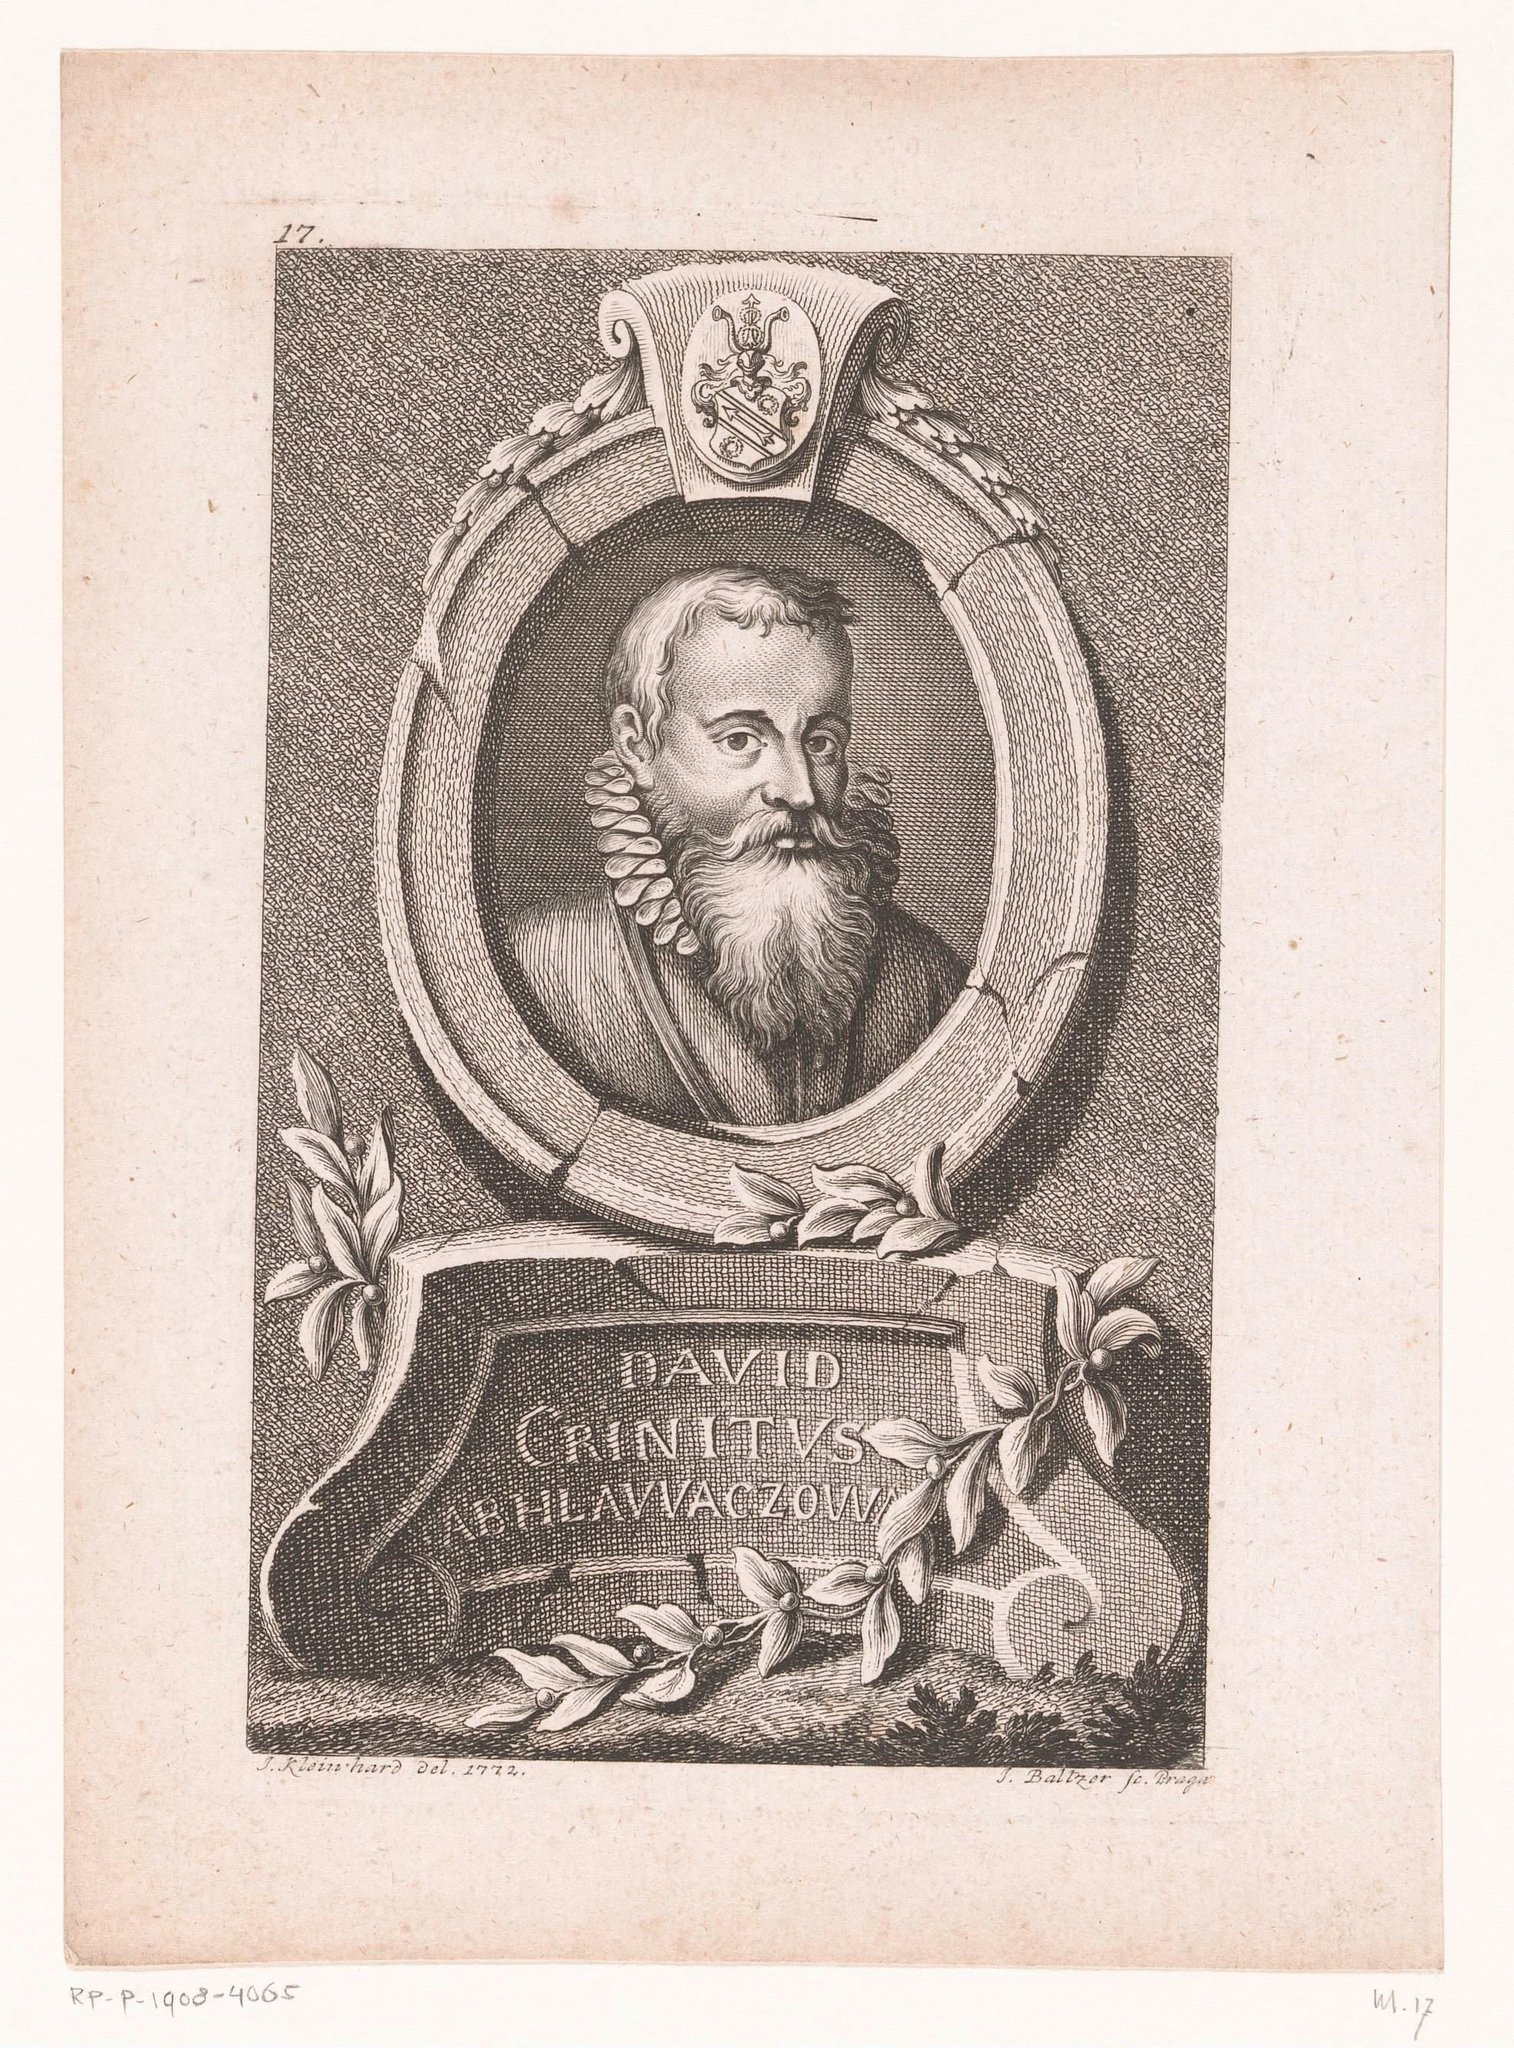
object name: print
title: Portret van David Crinitus z Hlavácova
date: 1772-1799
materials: paper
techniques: engraving, etching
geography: prague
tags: historical persons, writer, poet, author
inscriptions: collector's mark: Lugt 2228